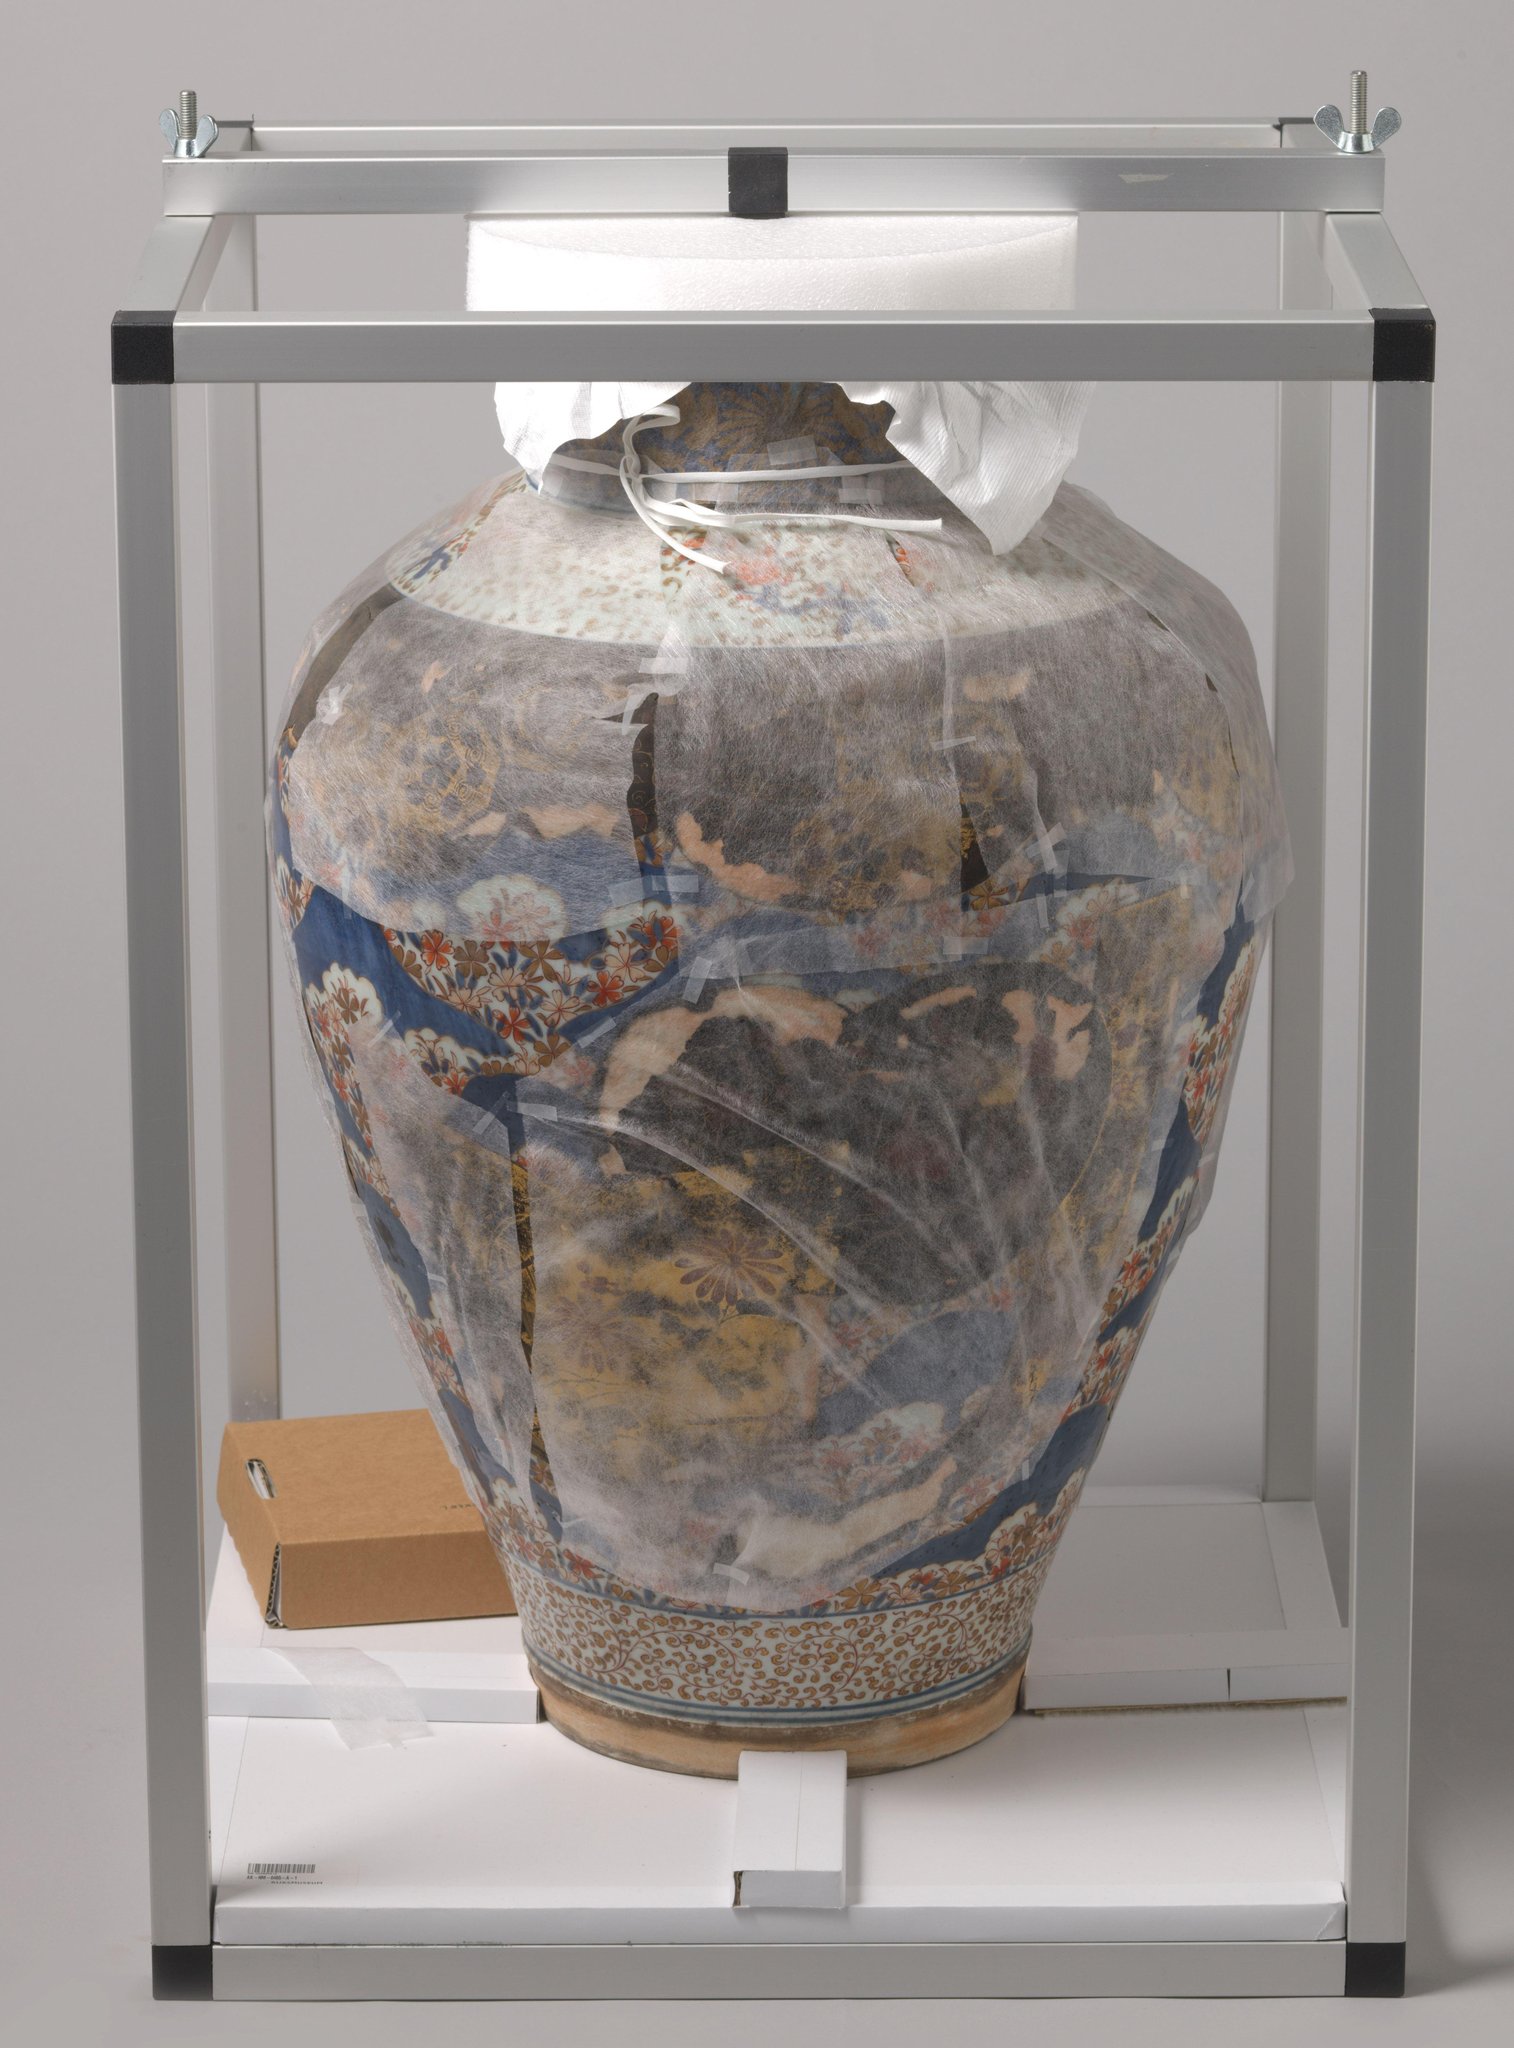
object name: dekselvaas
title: Dekselvaas met Imari-decoratie en lakwerk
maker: Anonymous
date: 1700-1725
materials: glaze, lacquer, paint, porcelain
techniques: firing, gilding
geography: japan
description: Eivormige vaas met een bolle deksel met recht uitstekende dekselrand en bekroond met een leeuw. Beschilderd in onderglazuur blauw, rode emails en goud met wolken en bloemtakken. Hierin ziin velden uitgespaard die zijn bedekt met lakwerk met bloemen.